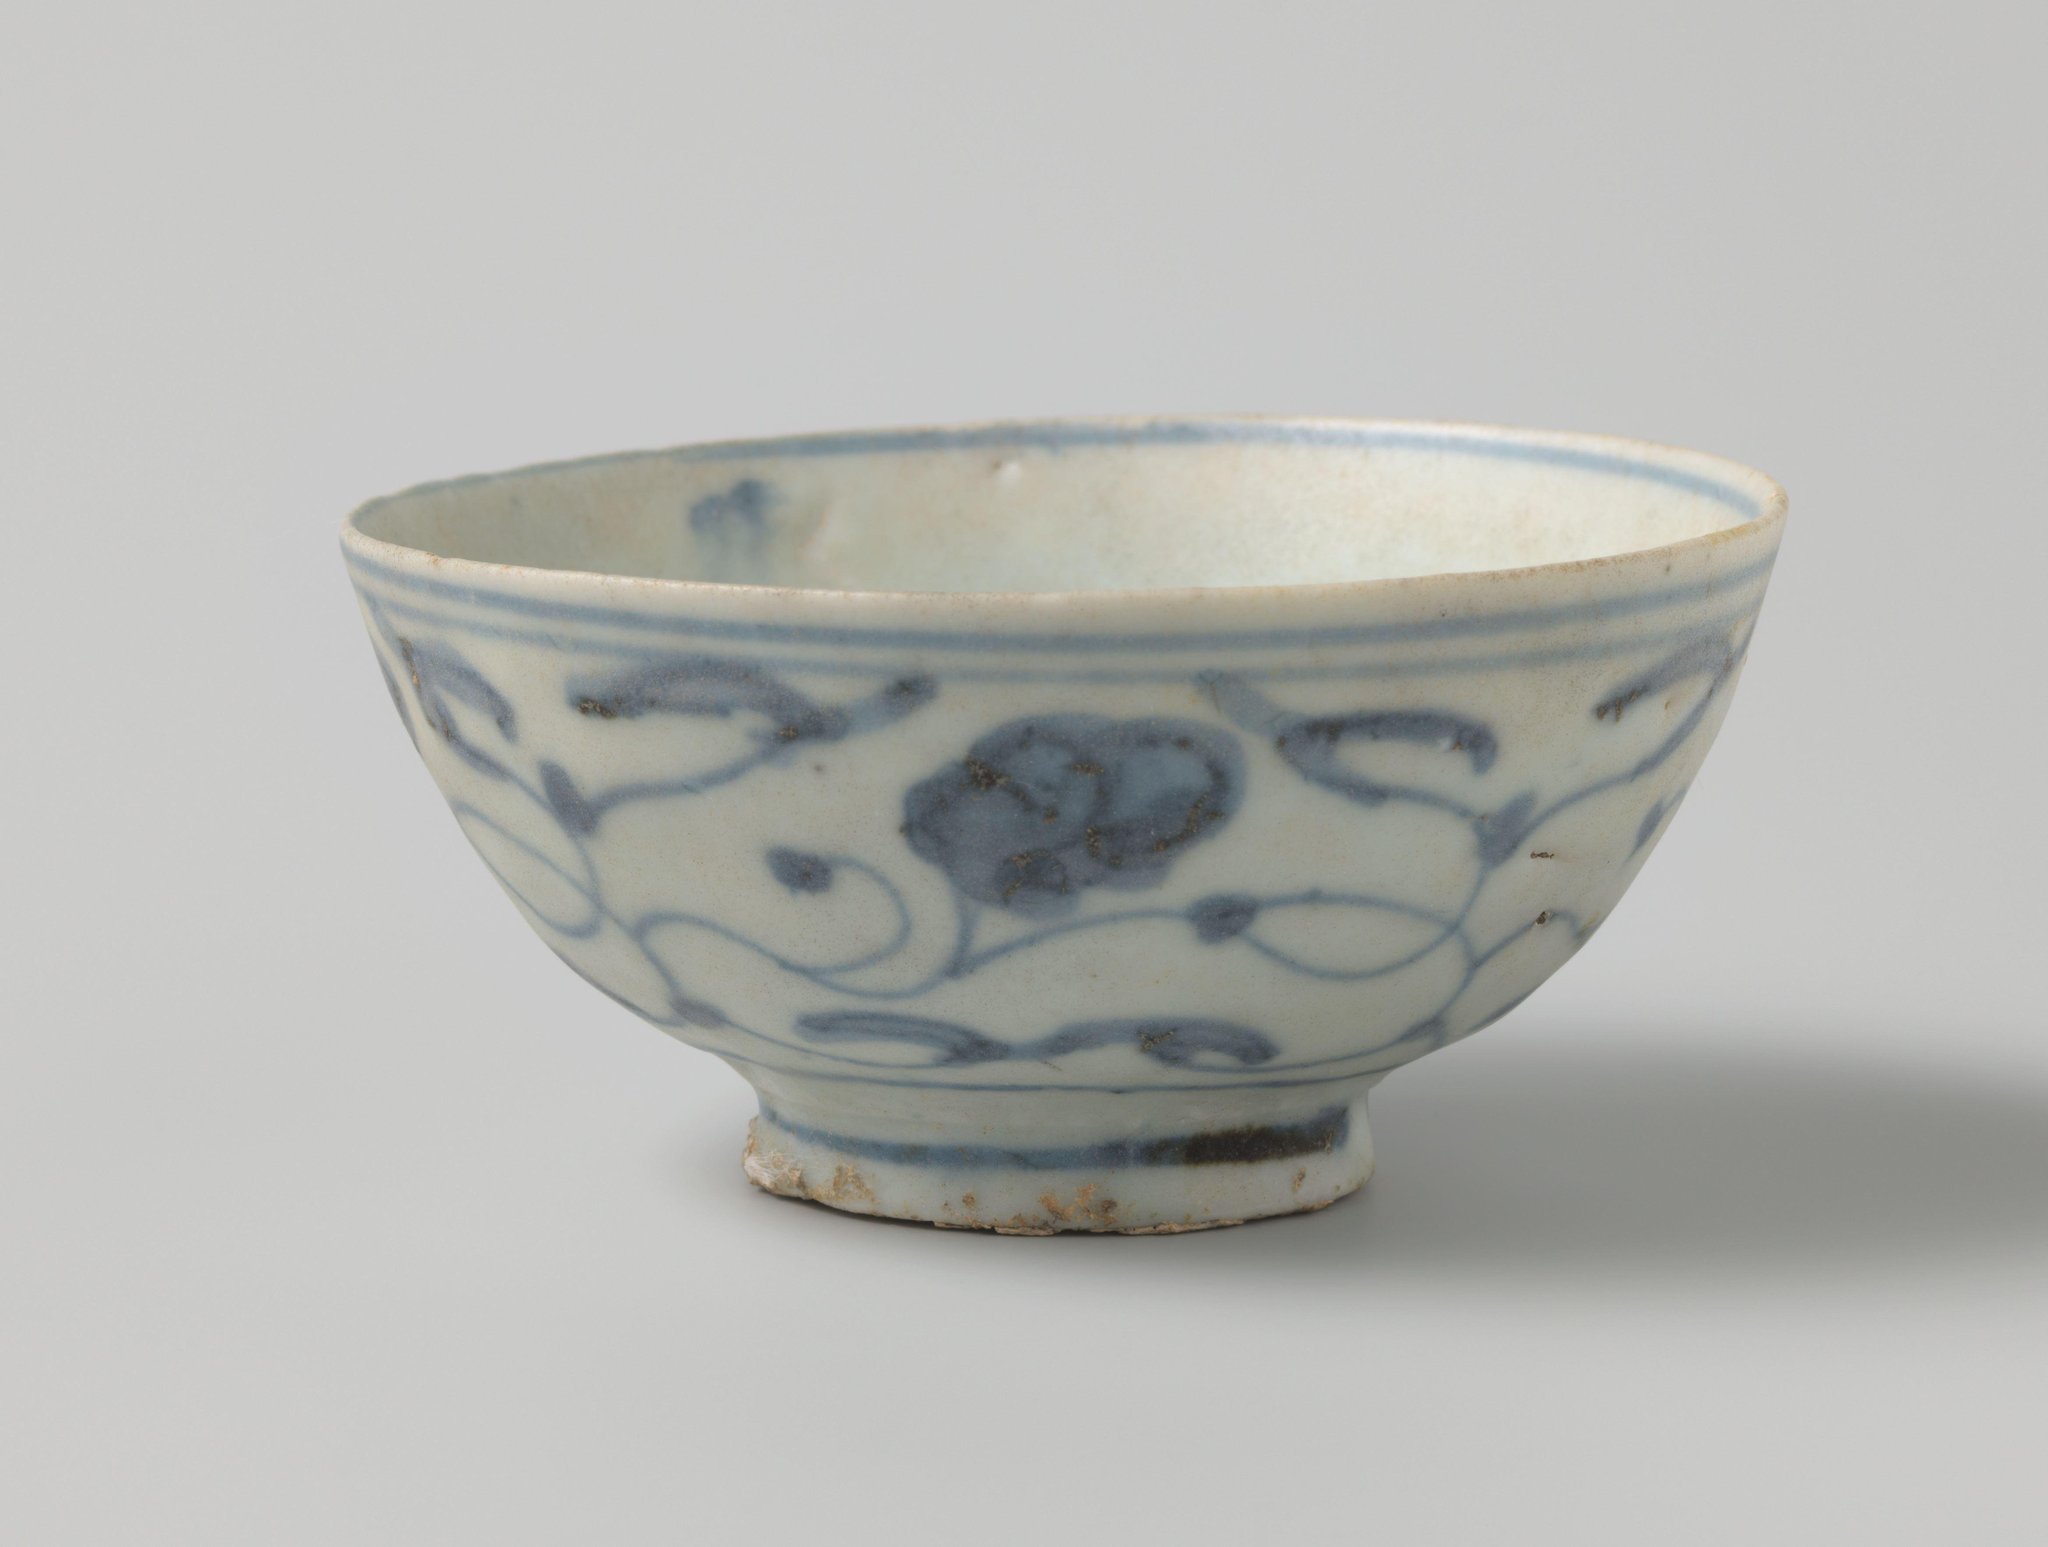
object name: bowl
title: Kom uit V.O.C.-schip de 'Witte Leeuw'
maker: Anonymous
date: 1613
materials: porcelain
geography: jingdezhen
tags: verenigde oostindische compagnie, sint-helena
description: Kom uit V.O.C.-schip de 'Witte Leeuw', compleet. De komt heeft een uitlopende rand en een afgeronde lip., de voetring staat naar buiten. De scherf kent veel verontreiniging en is van slechte kwaliteit. De basis is ruw afgewerkt. Het glazuur is melkachtig en blauwig en heeft pinholes. De decoratie is in onderglazuur en is dun in kobaltblauw geschilderd. Aan de binnenkant is de kom gedecoreerd met een bloem in een cirkel. De liprand heeft een cirkellijn. De buitenzijde is gedecoreerd met een doorlopend fries met gestileerde bloemen.